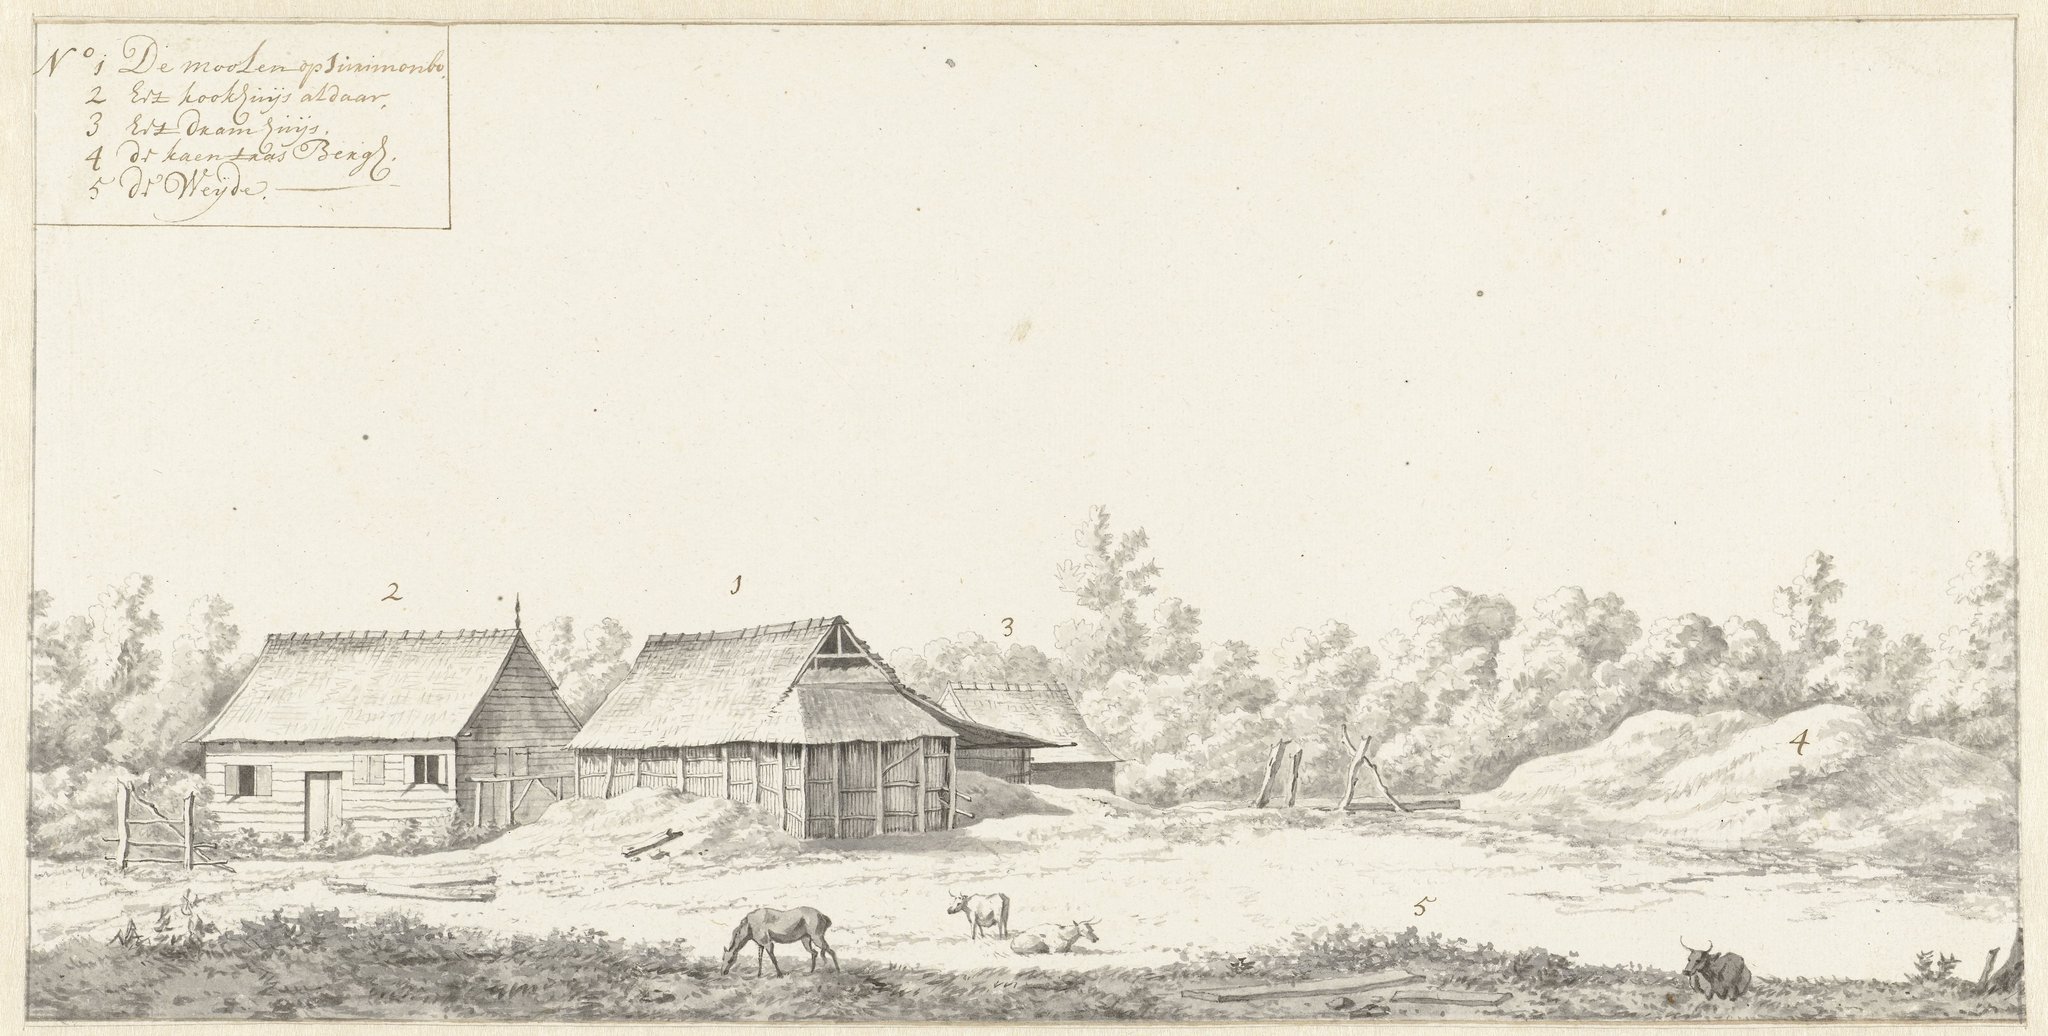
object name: drawing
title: View of Three Houses on the Surimombo Plantation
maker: dirk valkenburg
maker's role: draughtsman, painter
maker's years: 1675-1721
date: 1708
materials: chalk, ink, paper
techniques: brush, pen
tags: plantation, rural housing, e.g. country-house, villa, cottage, suriname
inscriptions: : ‘N0 1 De moolen op Surimonbo 2 het kookhuijs aldaar 3 het dramhuijs 4 de kaentras Bergh 5 de Weijde ’, date: ‘1708’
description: Drawings of the Palmeneribo, Waterland and Surimombo Plantations. With the viewing instructions that Valken burg noted on his drawings, Witsen was able to take a virtual walk around his plantations. There are hardly any people in the drawings, except possibly Valkenburg himself on the doorstep of the residence on Surimombo. The artist seems to have a particular eye for the buildings and for the sluice, which was important to regulate the water level. The sugar cane fields are also missing. For Witsen, Valkenburg was not only a link between the two worlds, but also a filter.